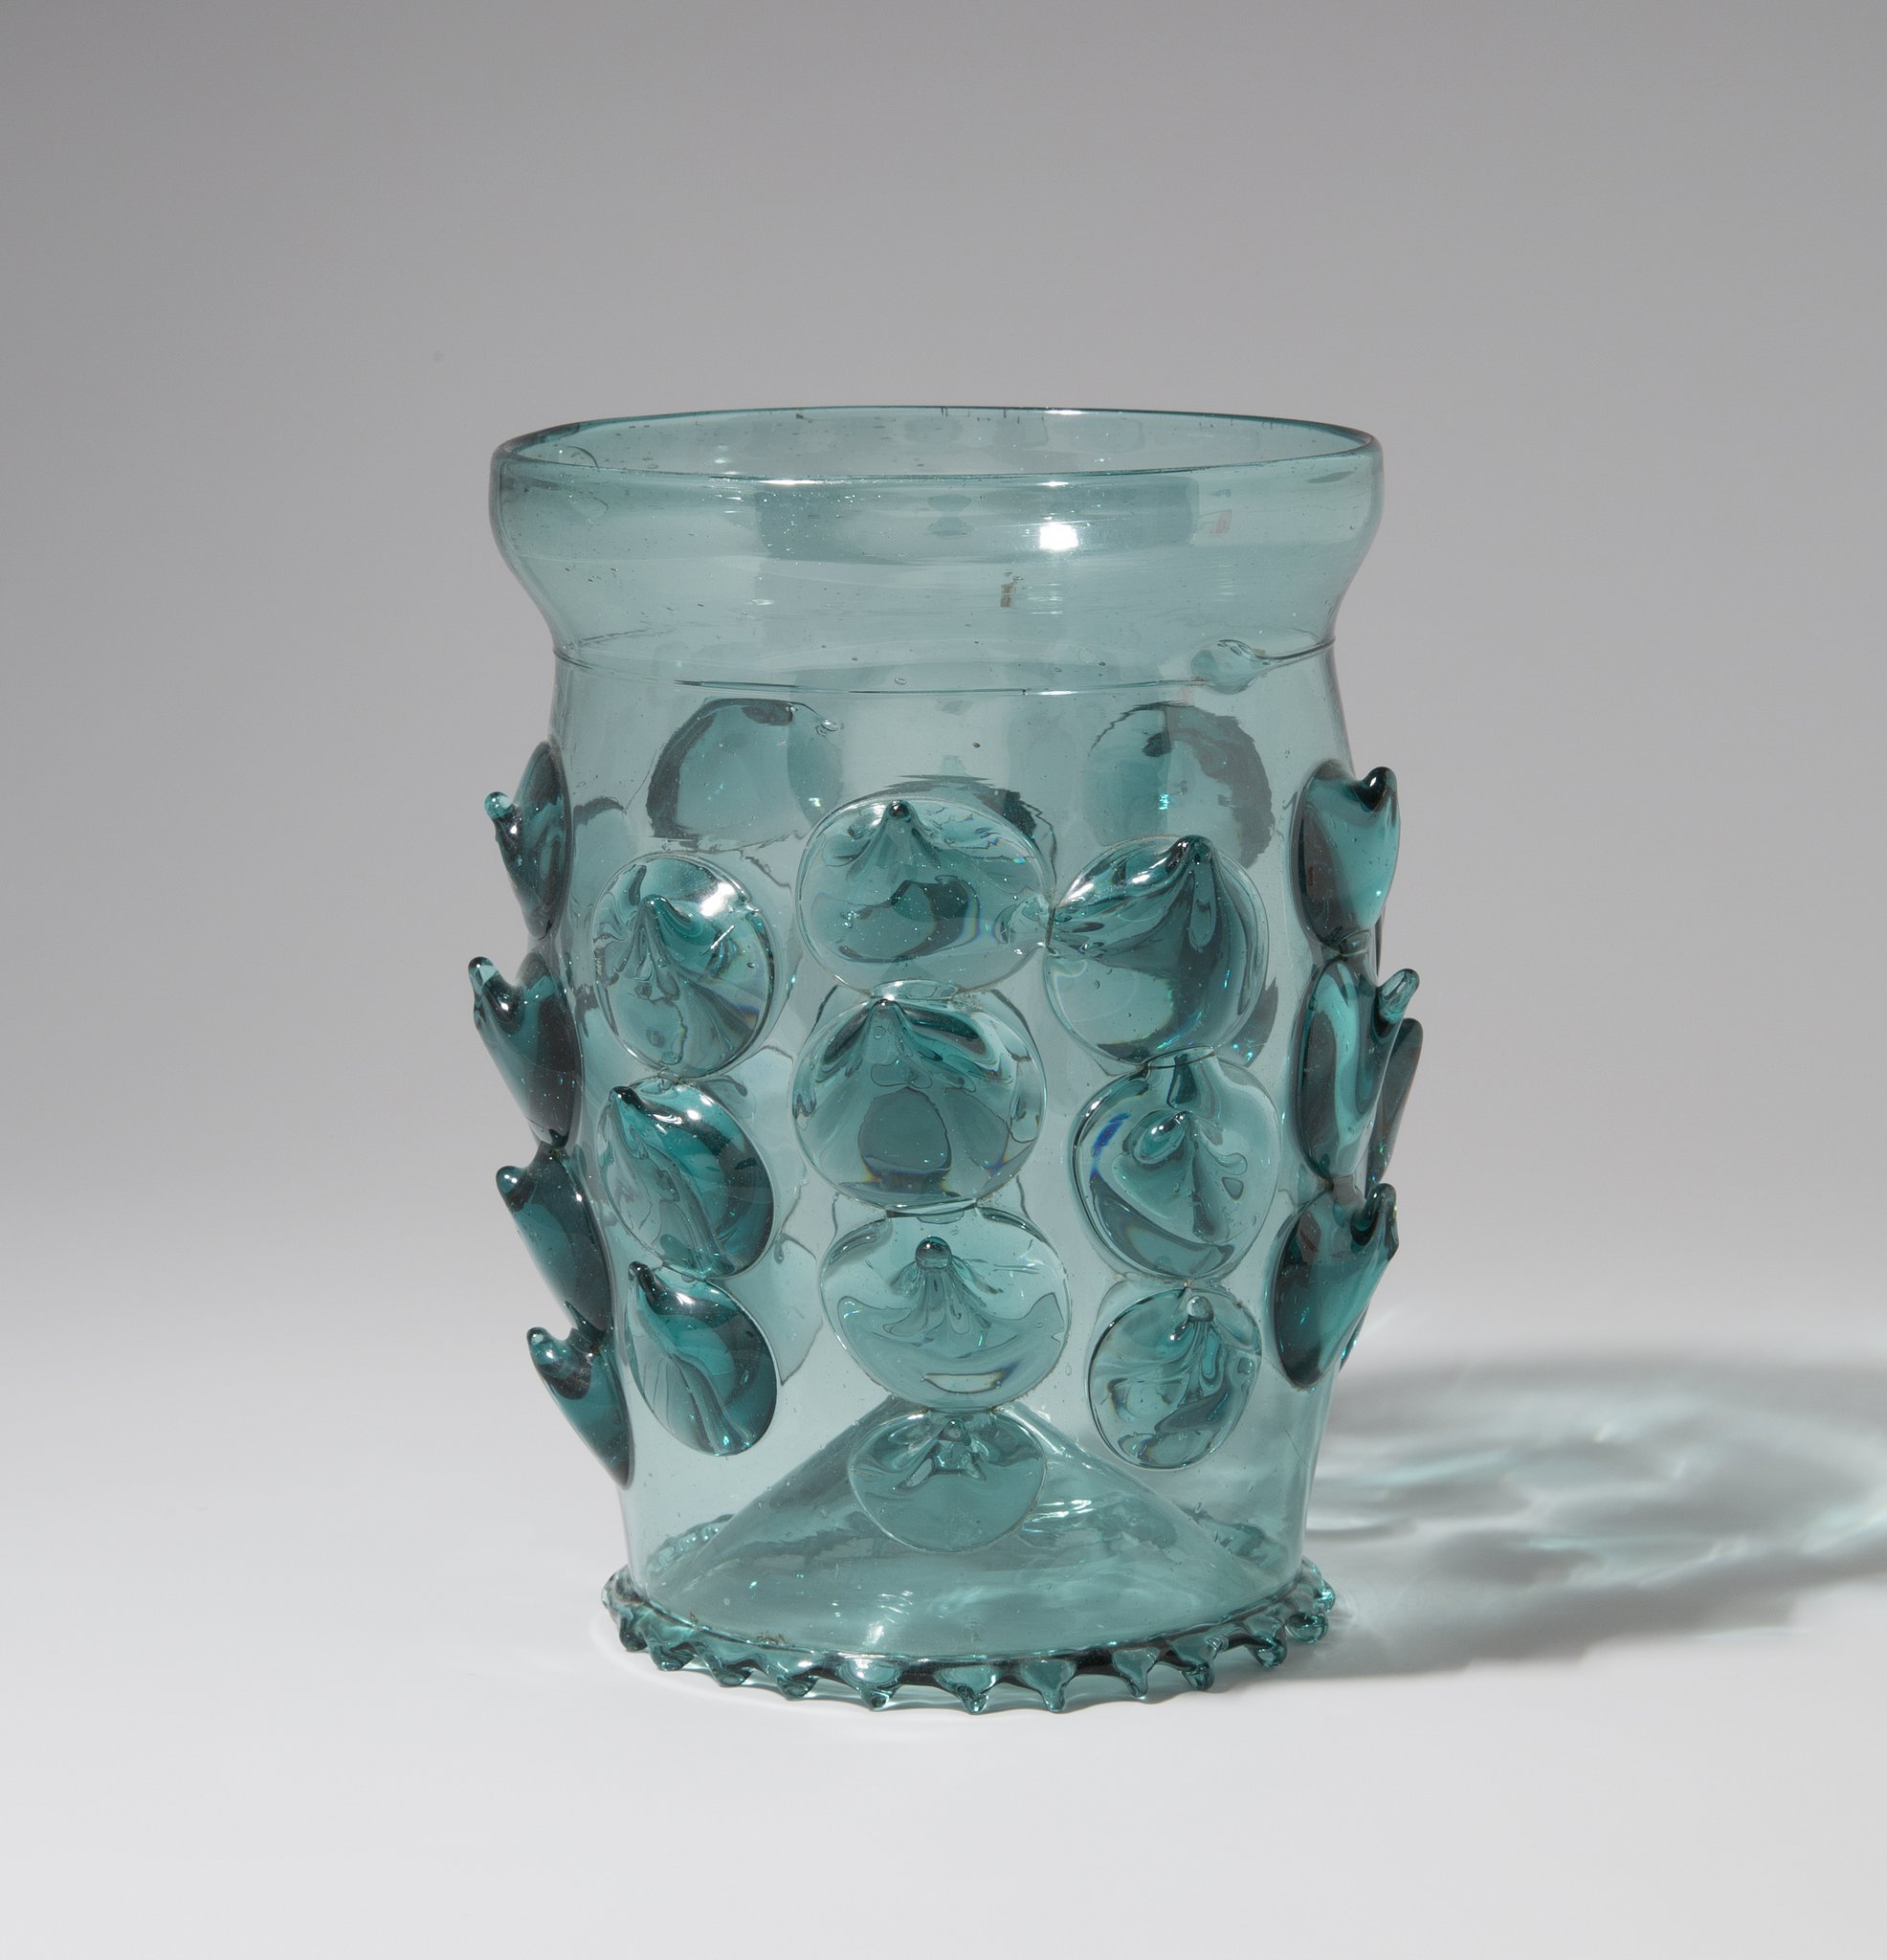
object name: beaker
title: Beaker (Krautstrunk)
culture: german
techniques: glassblowing